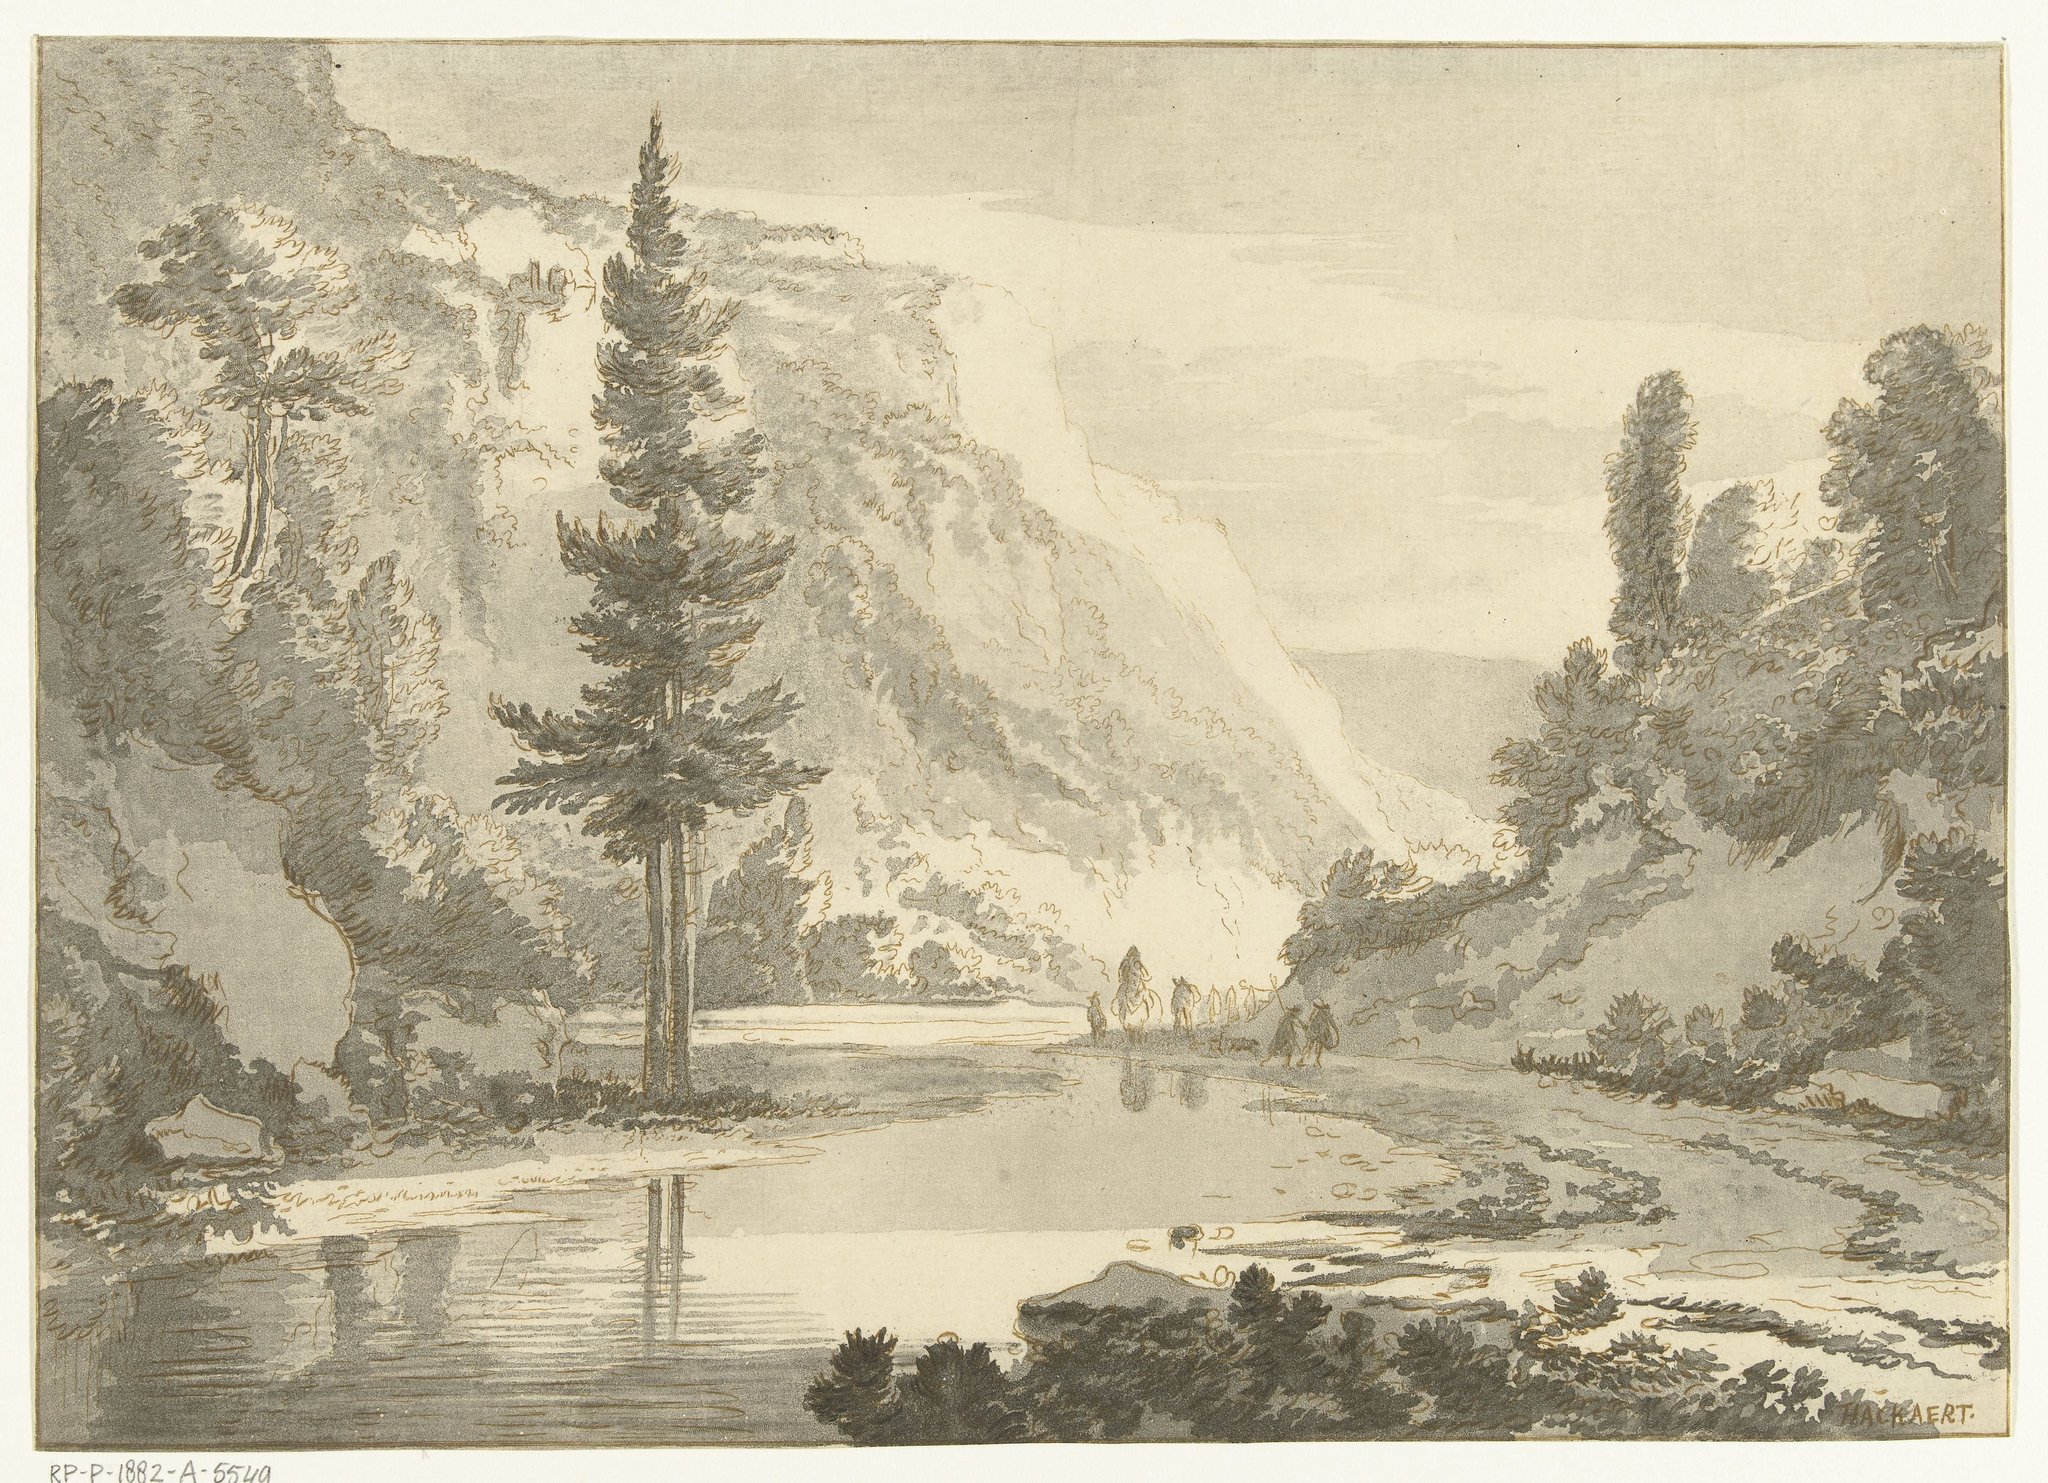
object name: print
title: Berglandschap met herders op een rivieroever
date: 1741-1803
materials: paper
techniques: aquatint, etching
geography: amsterdam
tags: river, mountains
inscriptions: collector's mark: Lugt 2228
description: Prent naar tekening van Jan Hackaert gedrukt met twee platen. Prent uit serie van negen prenttekeningen met acht landschappen en een zeegezicht naar Hollandse meesters uit de 17e eeuw. Cornelis Brouwer heeft in samenwerking met C.S. Roos een aantal prenttekeningen uitgegeven welke op het verso het signatuur C.Brouwer fecit en C.S. Roos excudit Amst. dragen, zie Huffel 1921, p. 33-35.